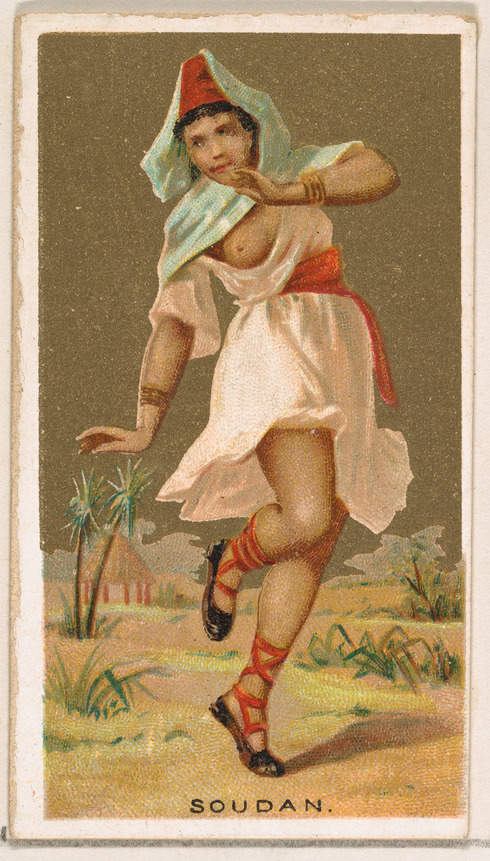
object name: print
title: Soudan, from the Dancing Girls of the World series (N185) issued by Wm. S. Kimball & Co.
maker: william s. kimball & company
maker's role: publisher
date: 1889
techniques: color lithograph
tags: women,female nudes,dancing,dancers